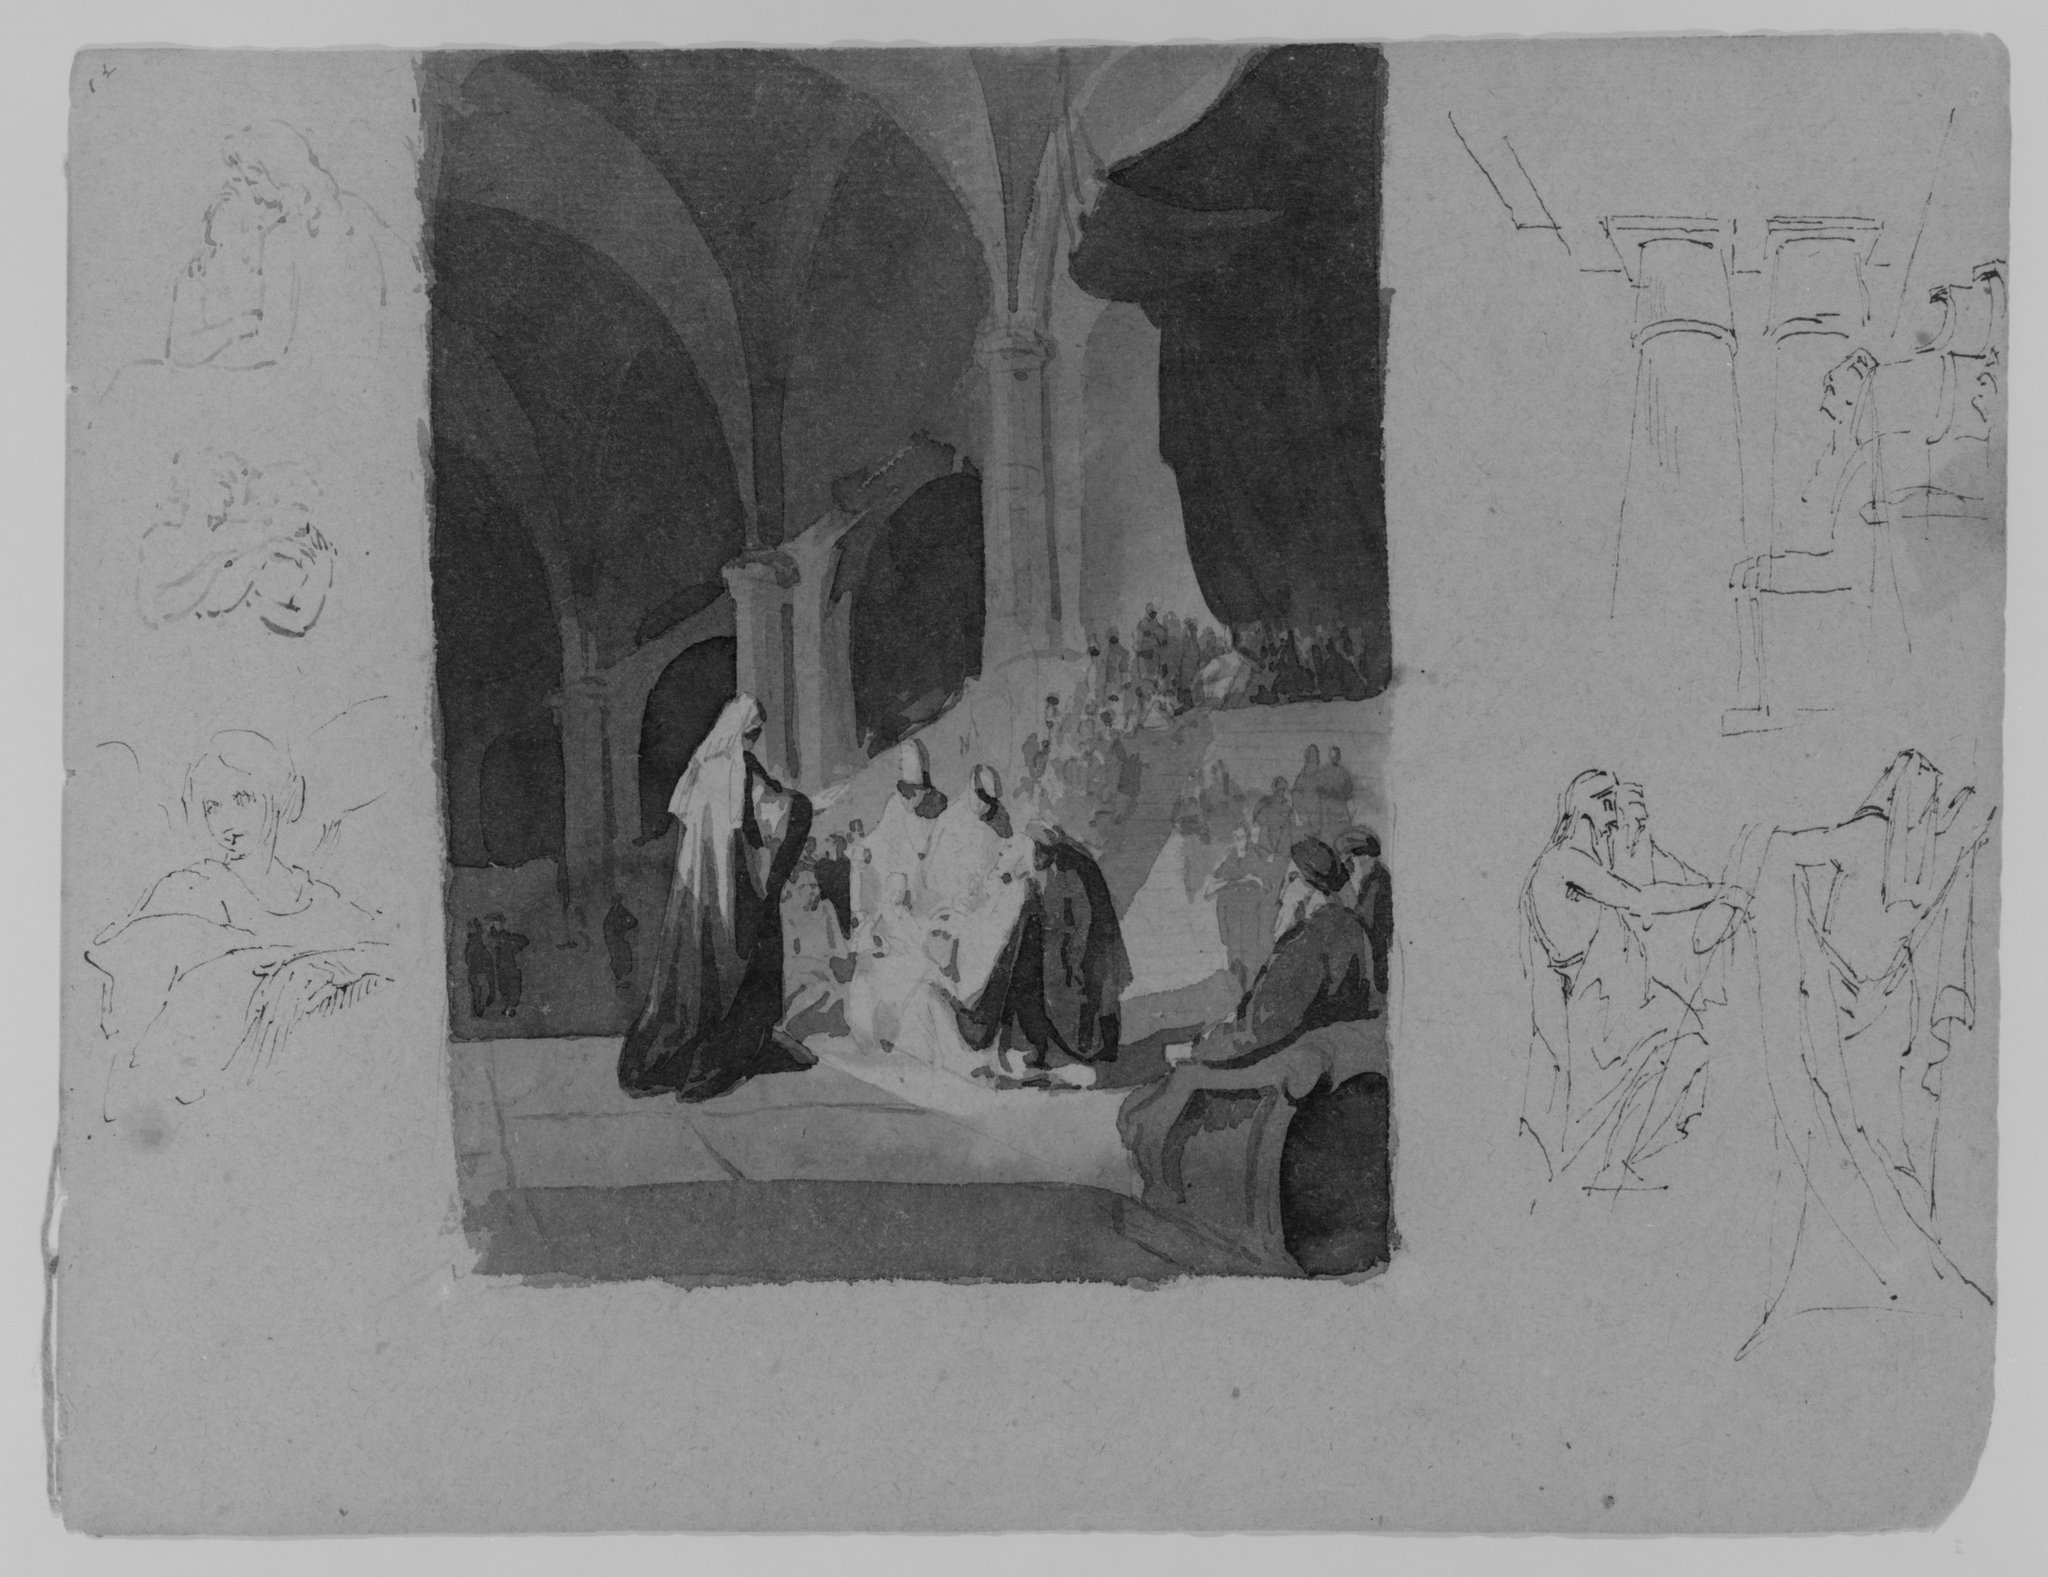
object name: drawing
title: Presentation Scene (from Sketchbook)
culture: american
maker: thomas sully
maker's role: artist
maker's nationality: american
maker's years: 1783-1872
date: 1810-1820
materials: ink, paper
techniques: wash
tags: men,women